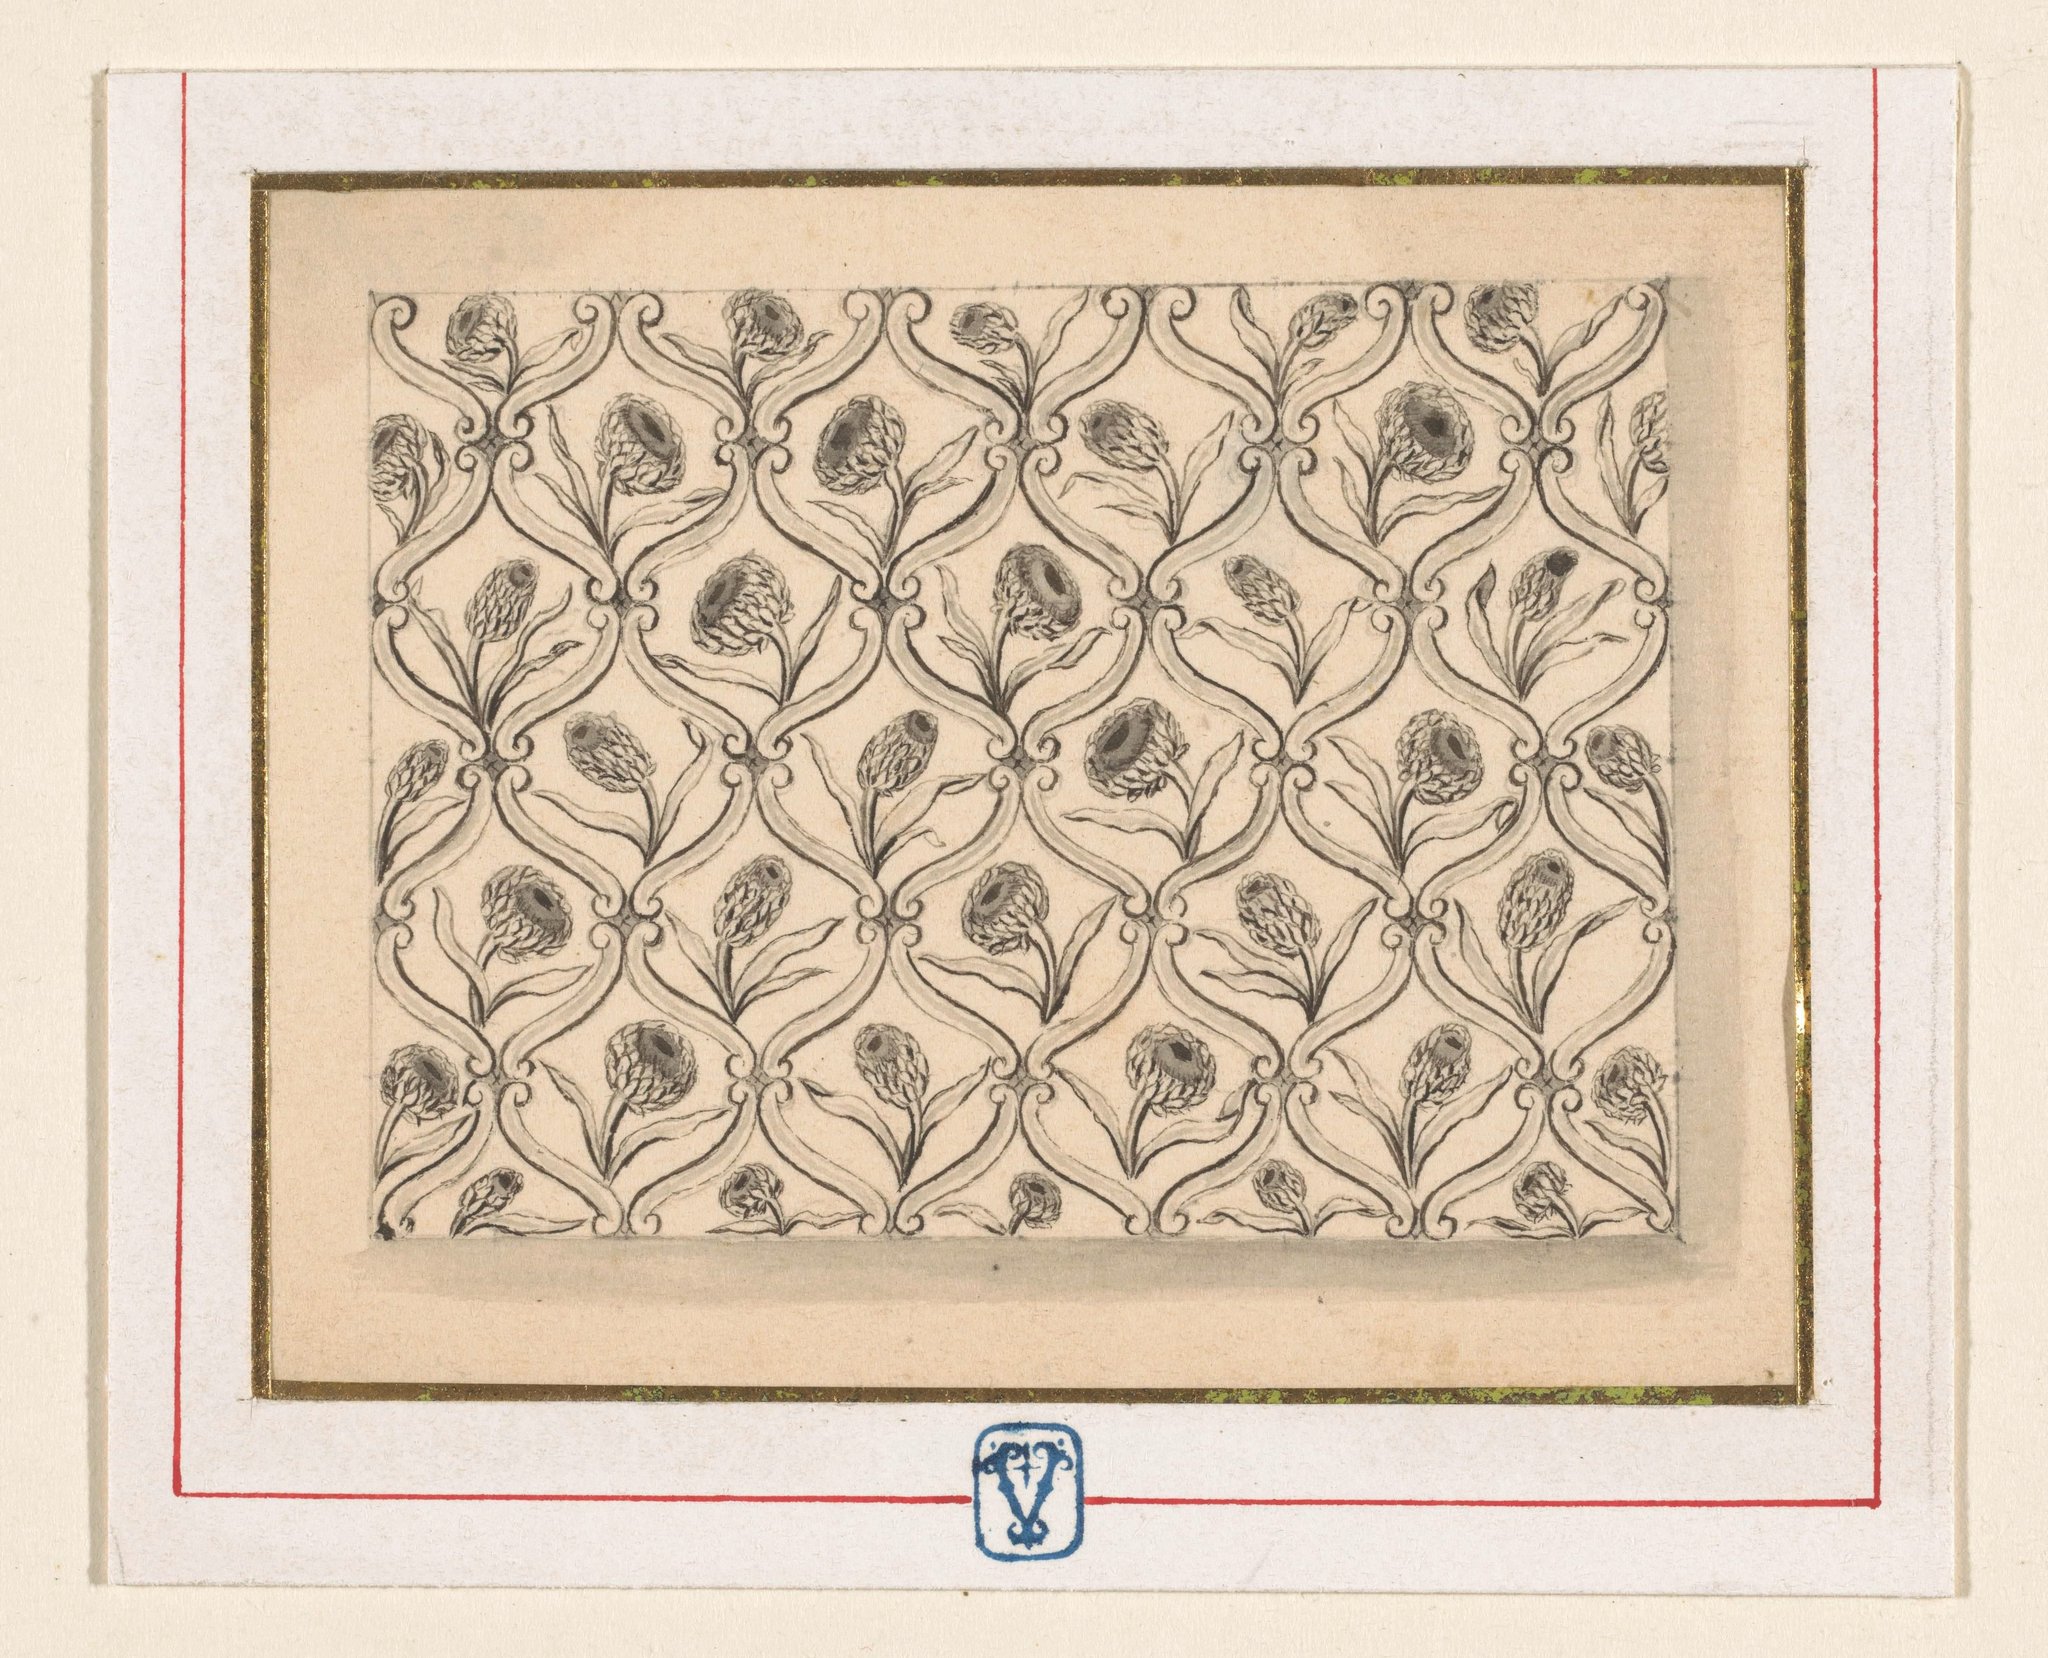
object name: drawing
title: Patroon van vlakken met daarin bloemen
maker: jacques vauquer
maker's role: draughtsman, print maker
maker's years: 1621-1686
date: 1631-1686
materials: ink, paper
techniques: brush, pen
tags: flowers ~ ornament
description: Ontwerp voor een all-over-pattern met door antithetische voluntbanden omschreven vlakken waarin telkens één bloem is afgebeeld.